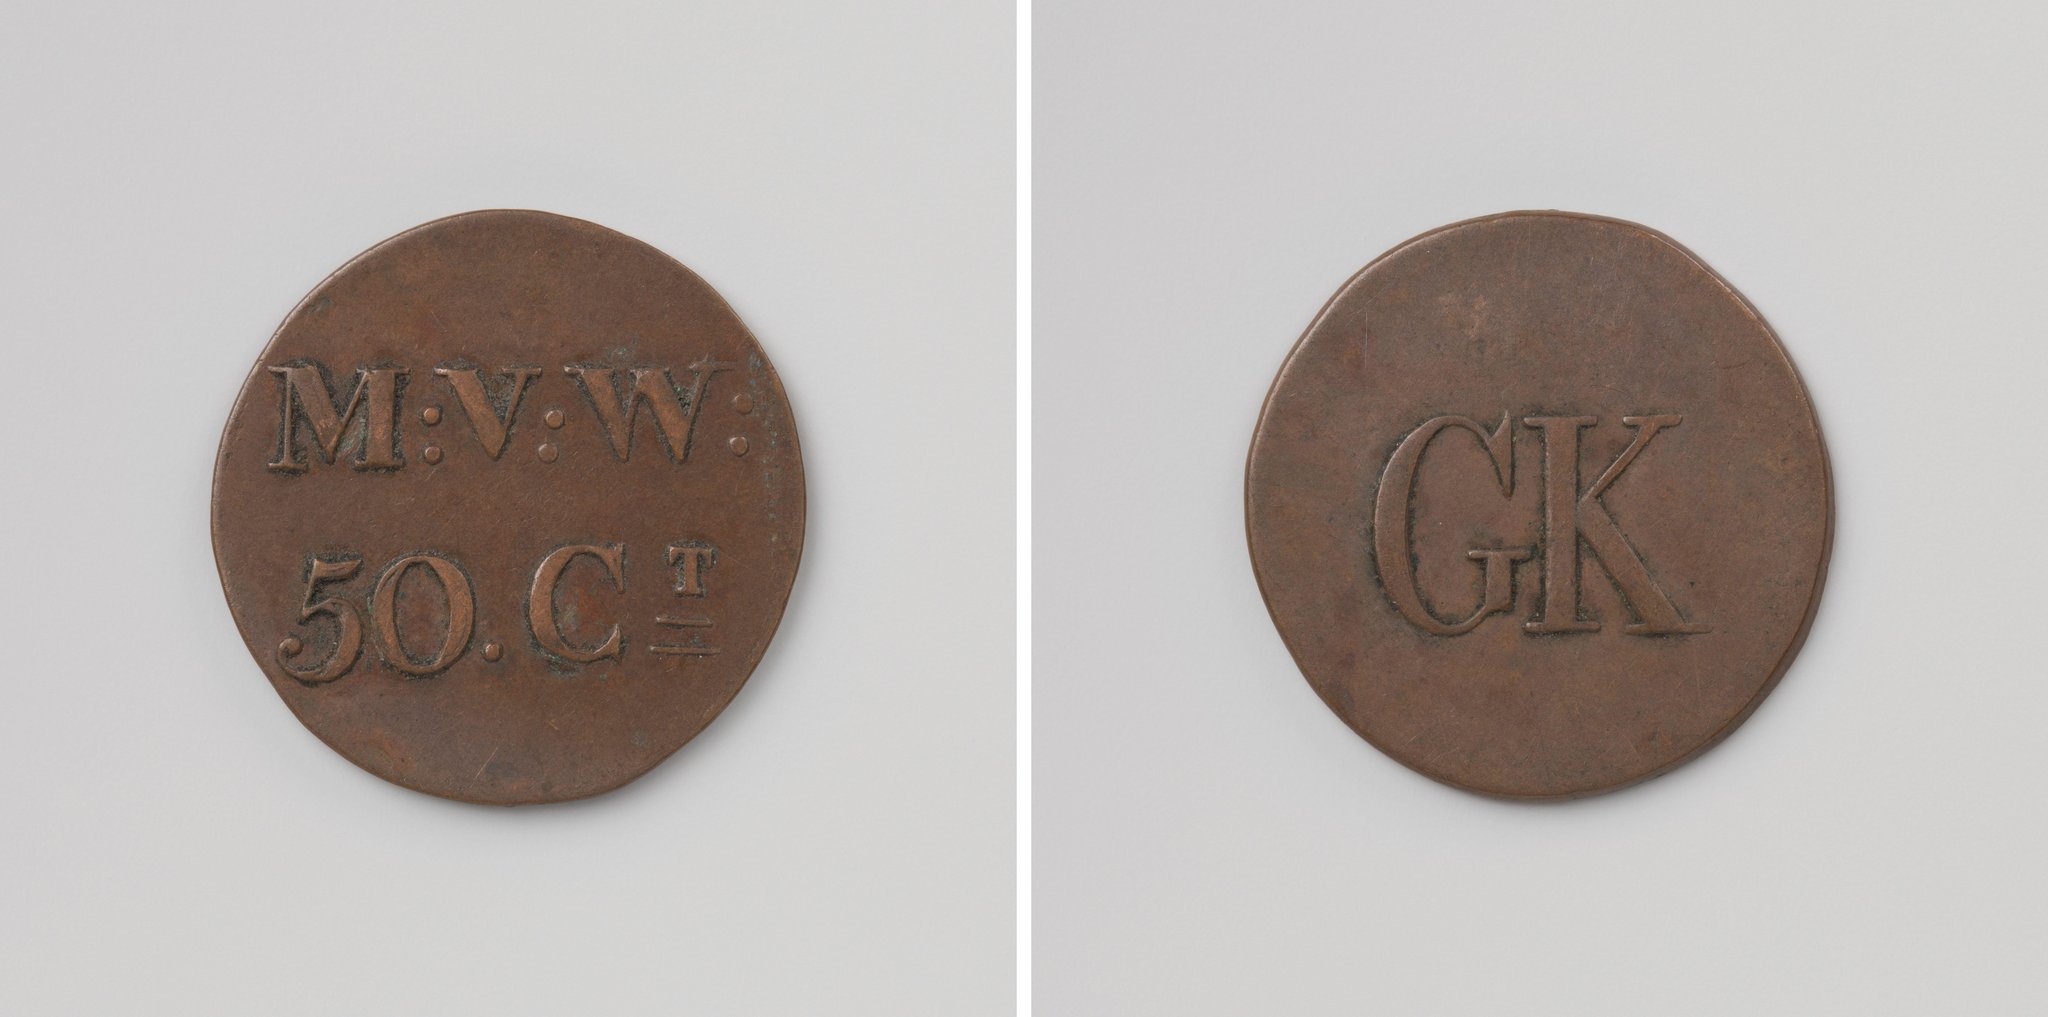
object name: huismunt prison money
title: Huismunt geslagen op last van de Maatschappij van Weldadigheid ter waarde van 50 cent, ten behoeve van de Gewone Koloniën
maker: Anonymous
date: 1818-1859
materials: copper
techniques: striking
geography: netherlands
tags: maatschappij van weldadigheid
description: Voorzijde: opschrift boven waardeaanduiding. Keerzijde: opschrift G en K